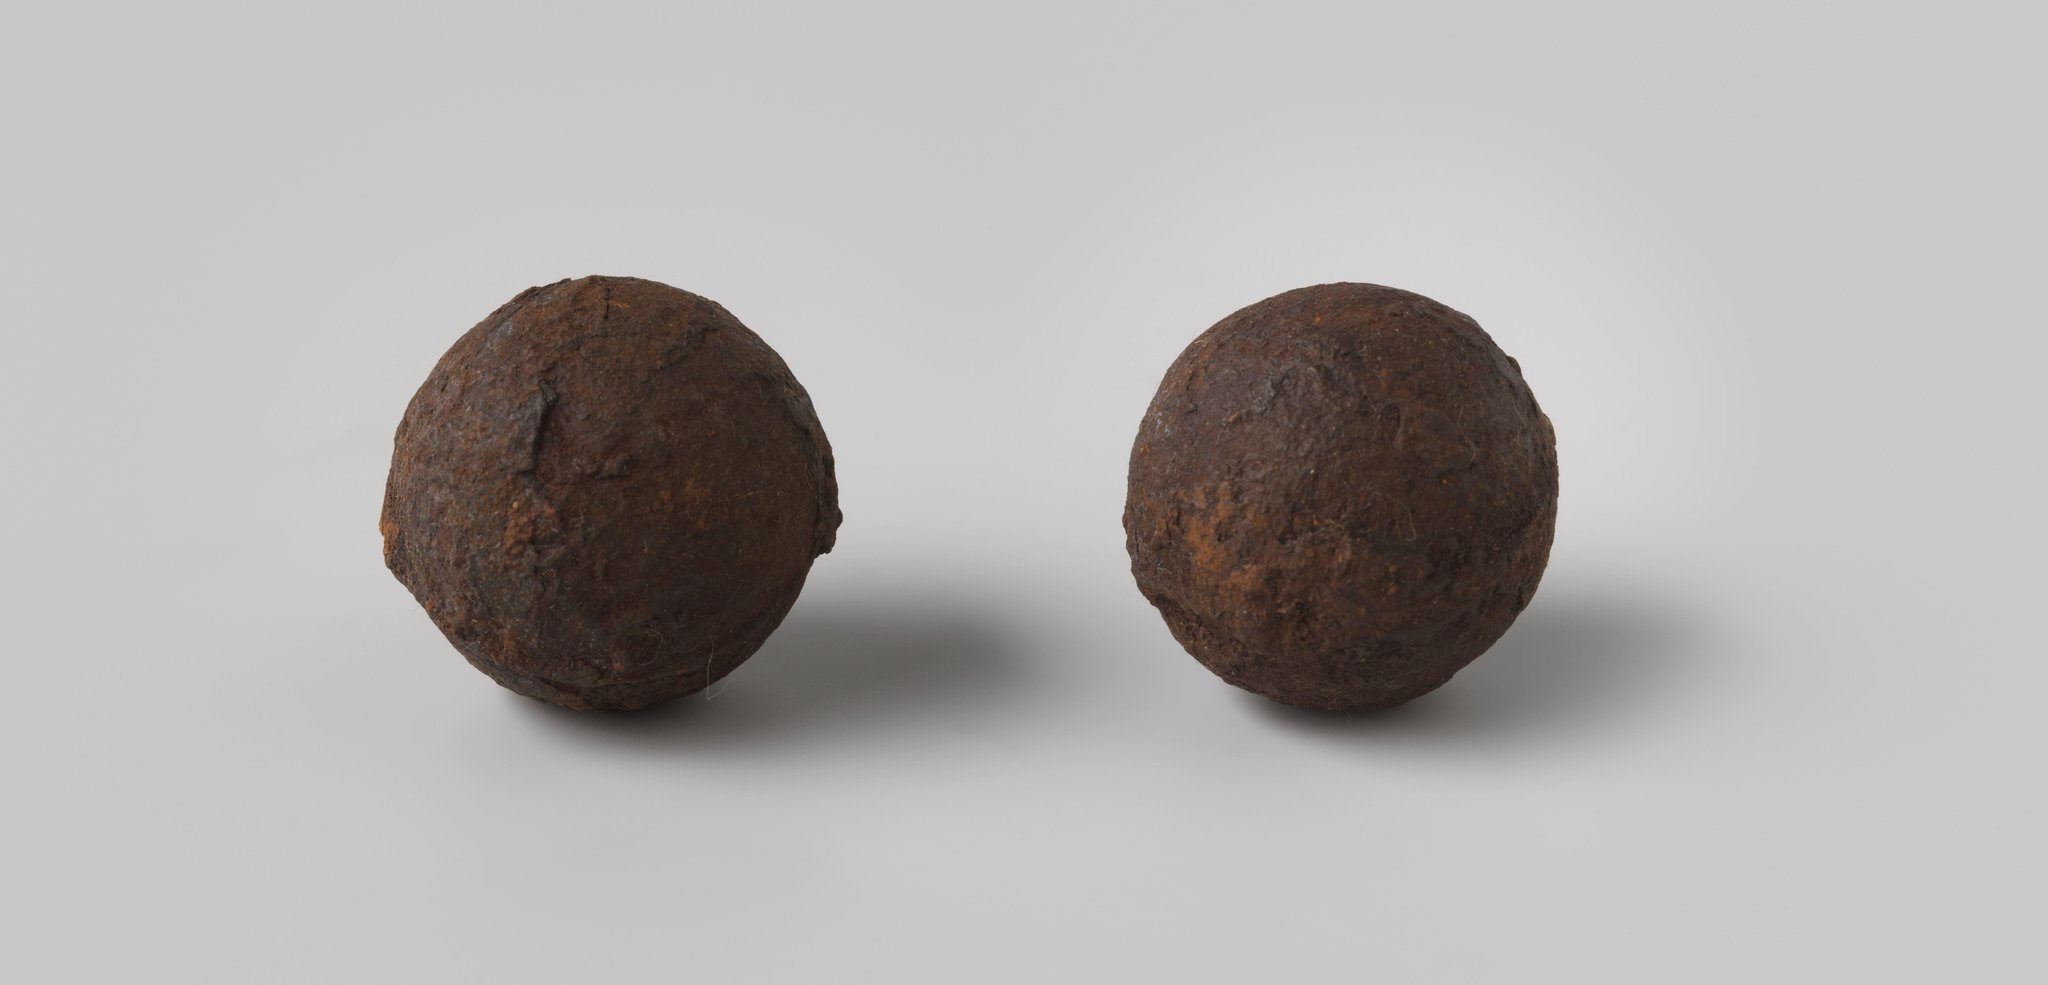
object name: bullet ammunition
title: Kogels uit het wrak van de Oost-Indiëvaarder Hollandia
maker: Anonymous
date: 1700-1743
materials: iron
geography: netherlands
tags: verenigde oostindische compagnie, hollandia (schip), annet